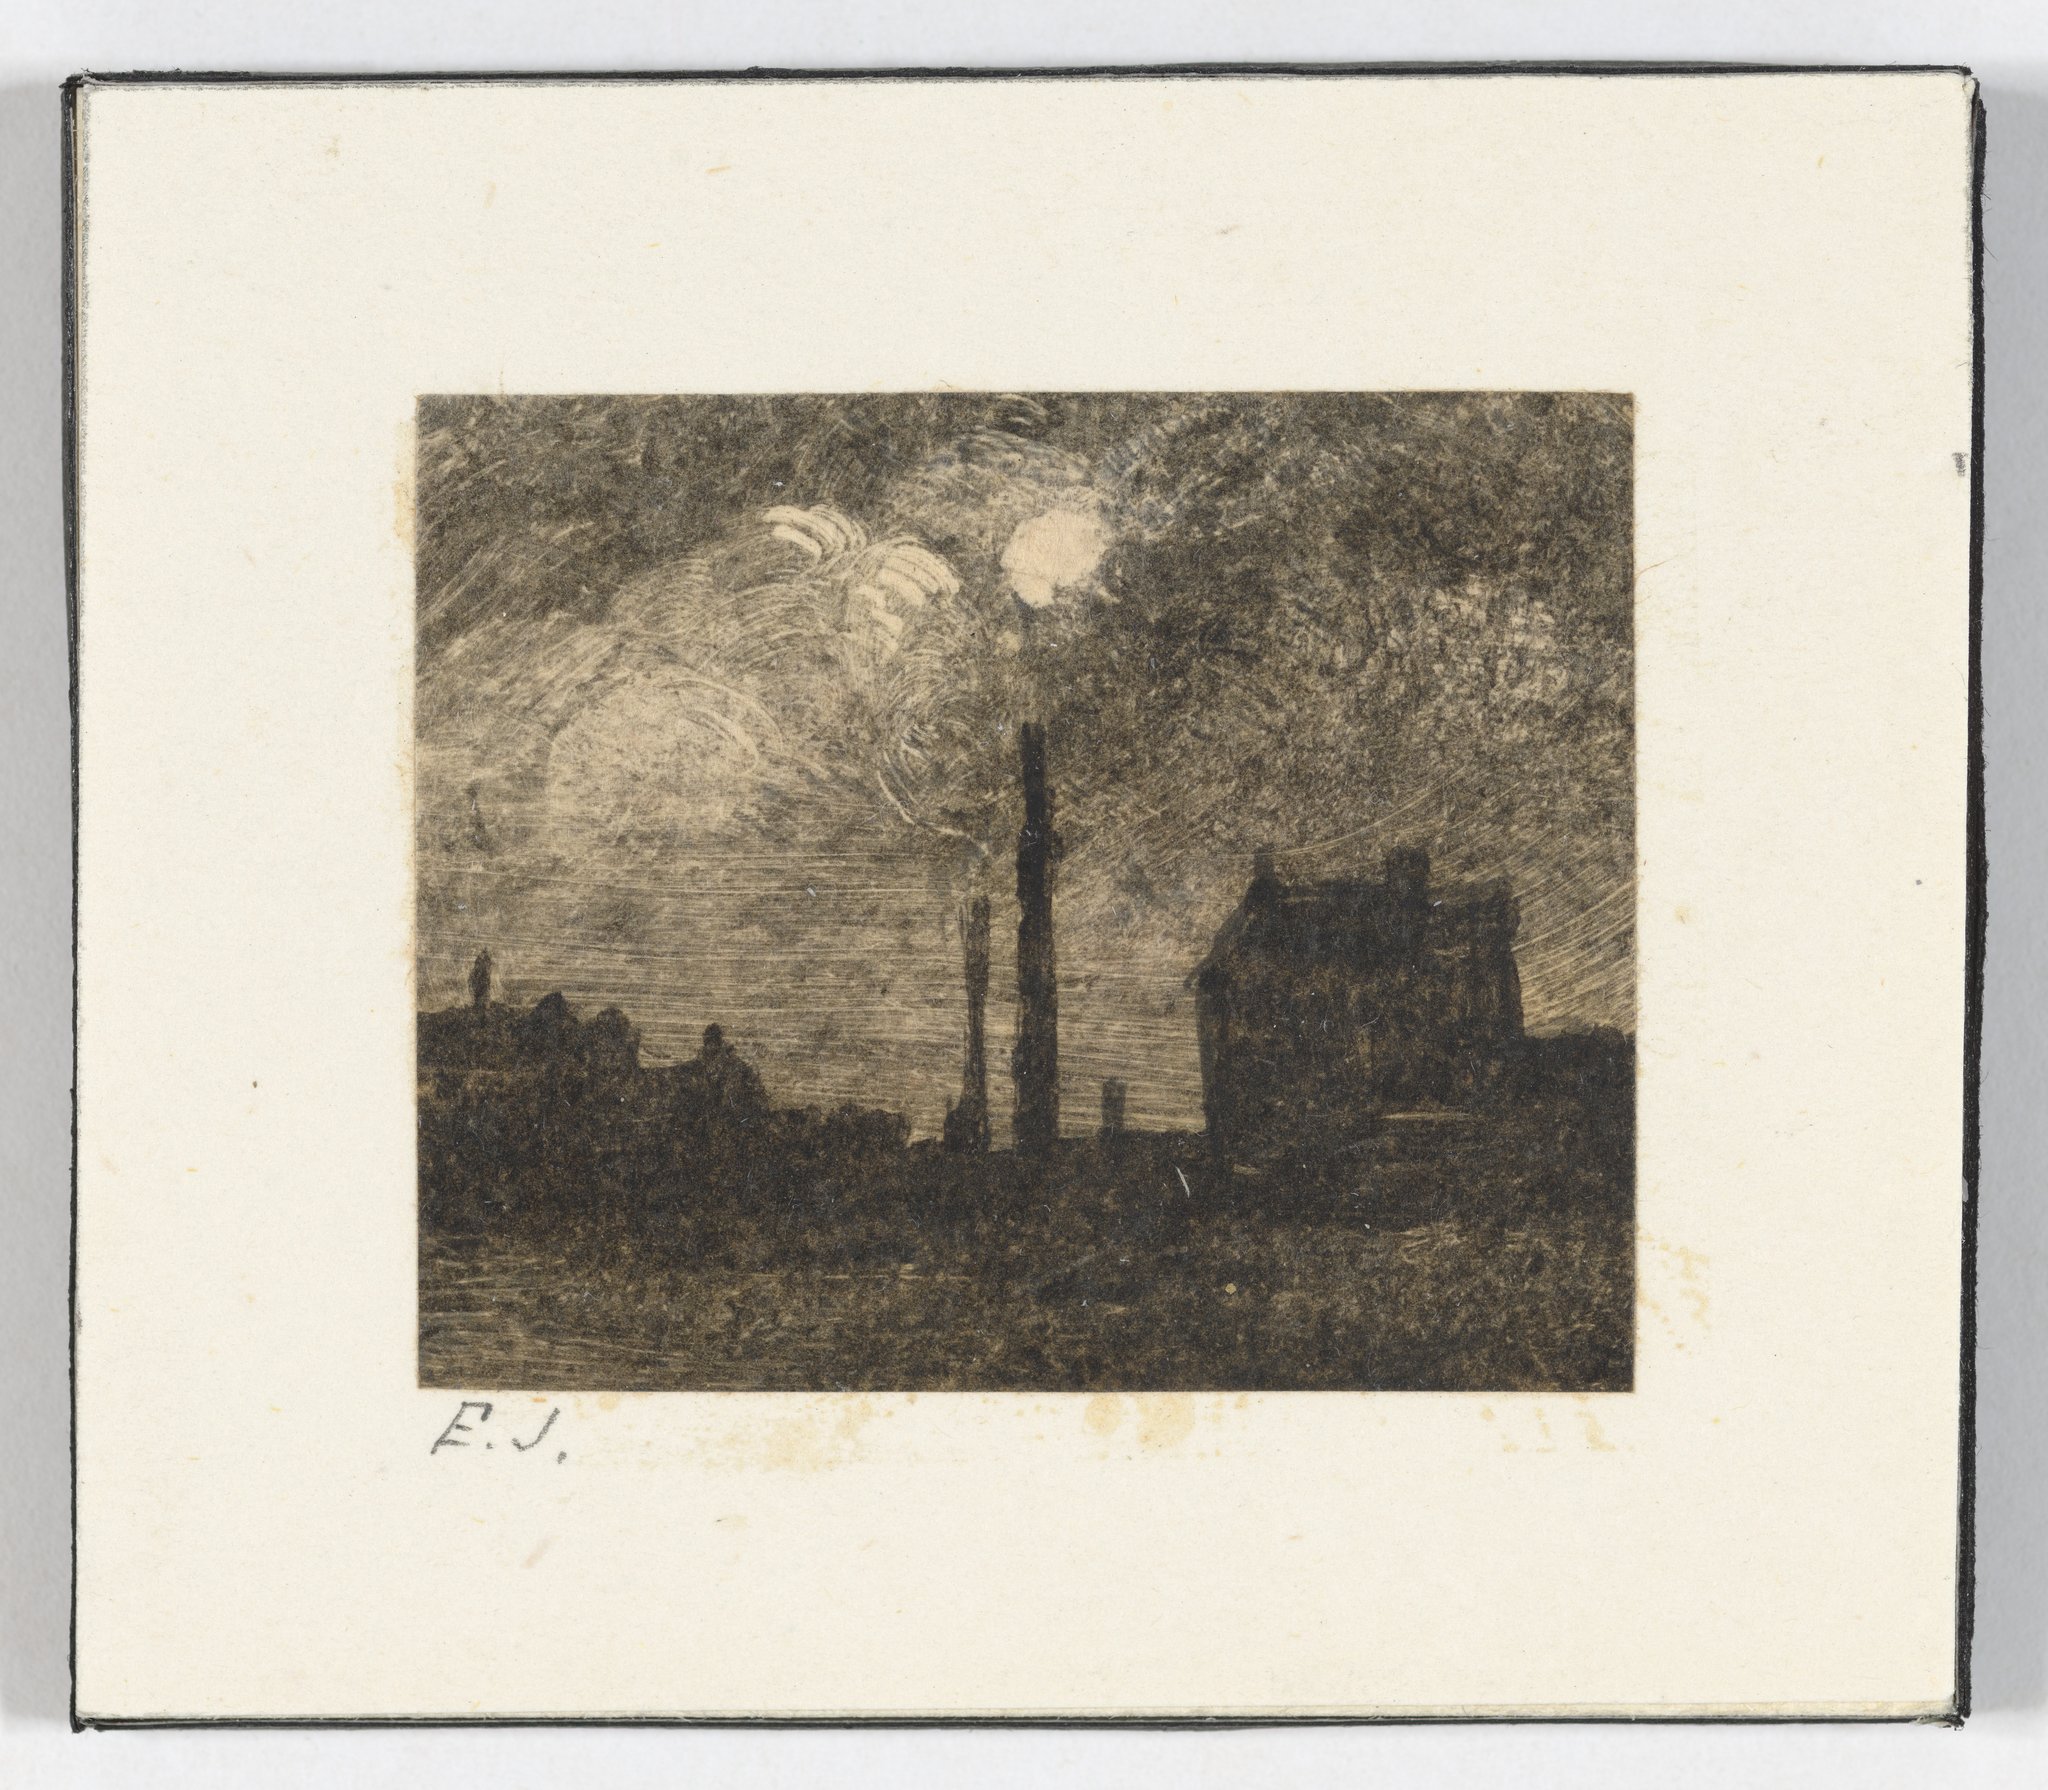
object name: drawing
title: Industrial Landscape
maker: frédéric juncker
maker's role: artist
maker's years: 1822-1906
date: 1880-1885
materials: paper, wax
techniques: brush, scraping